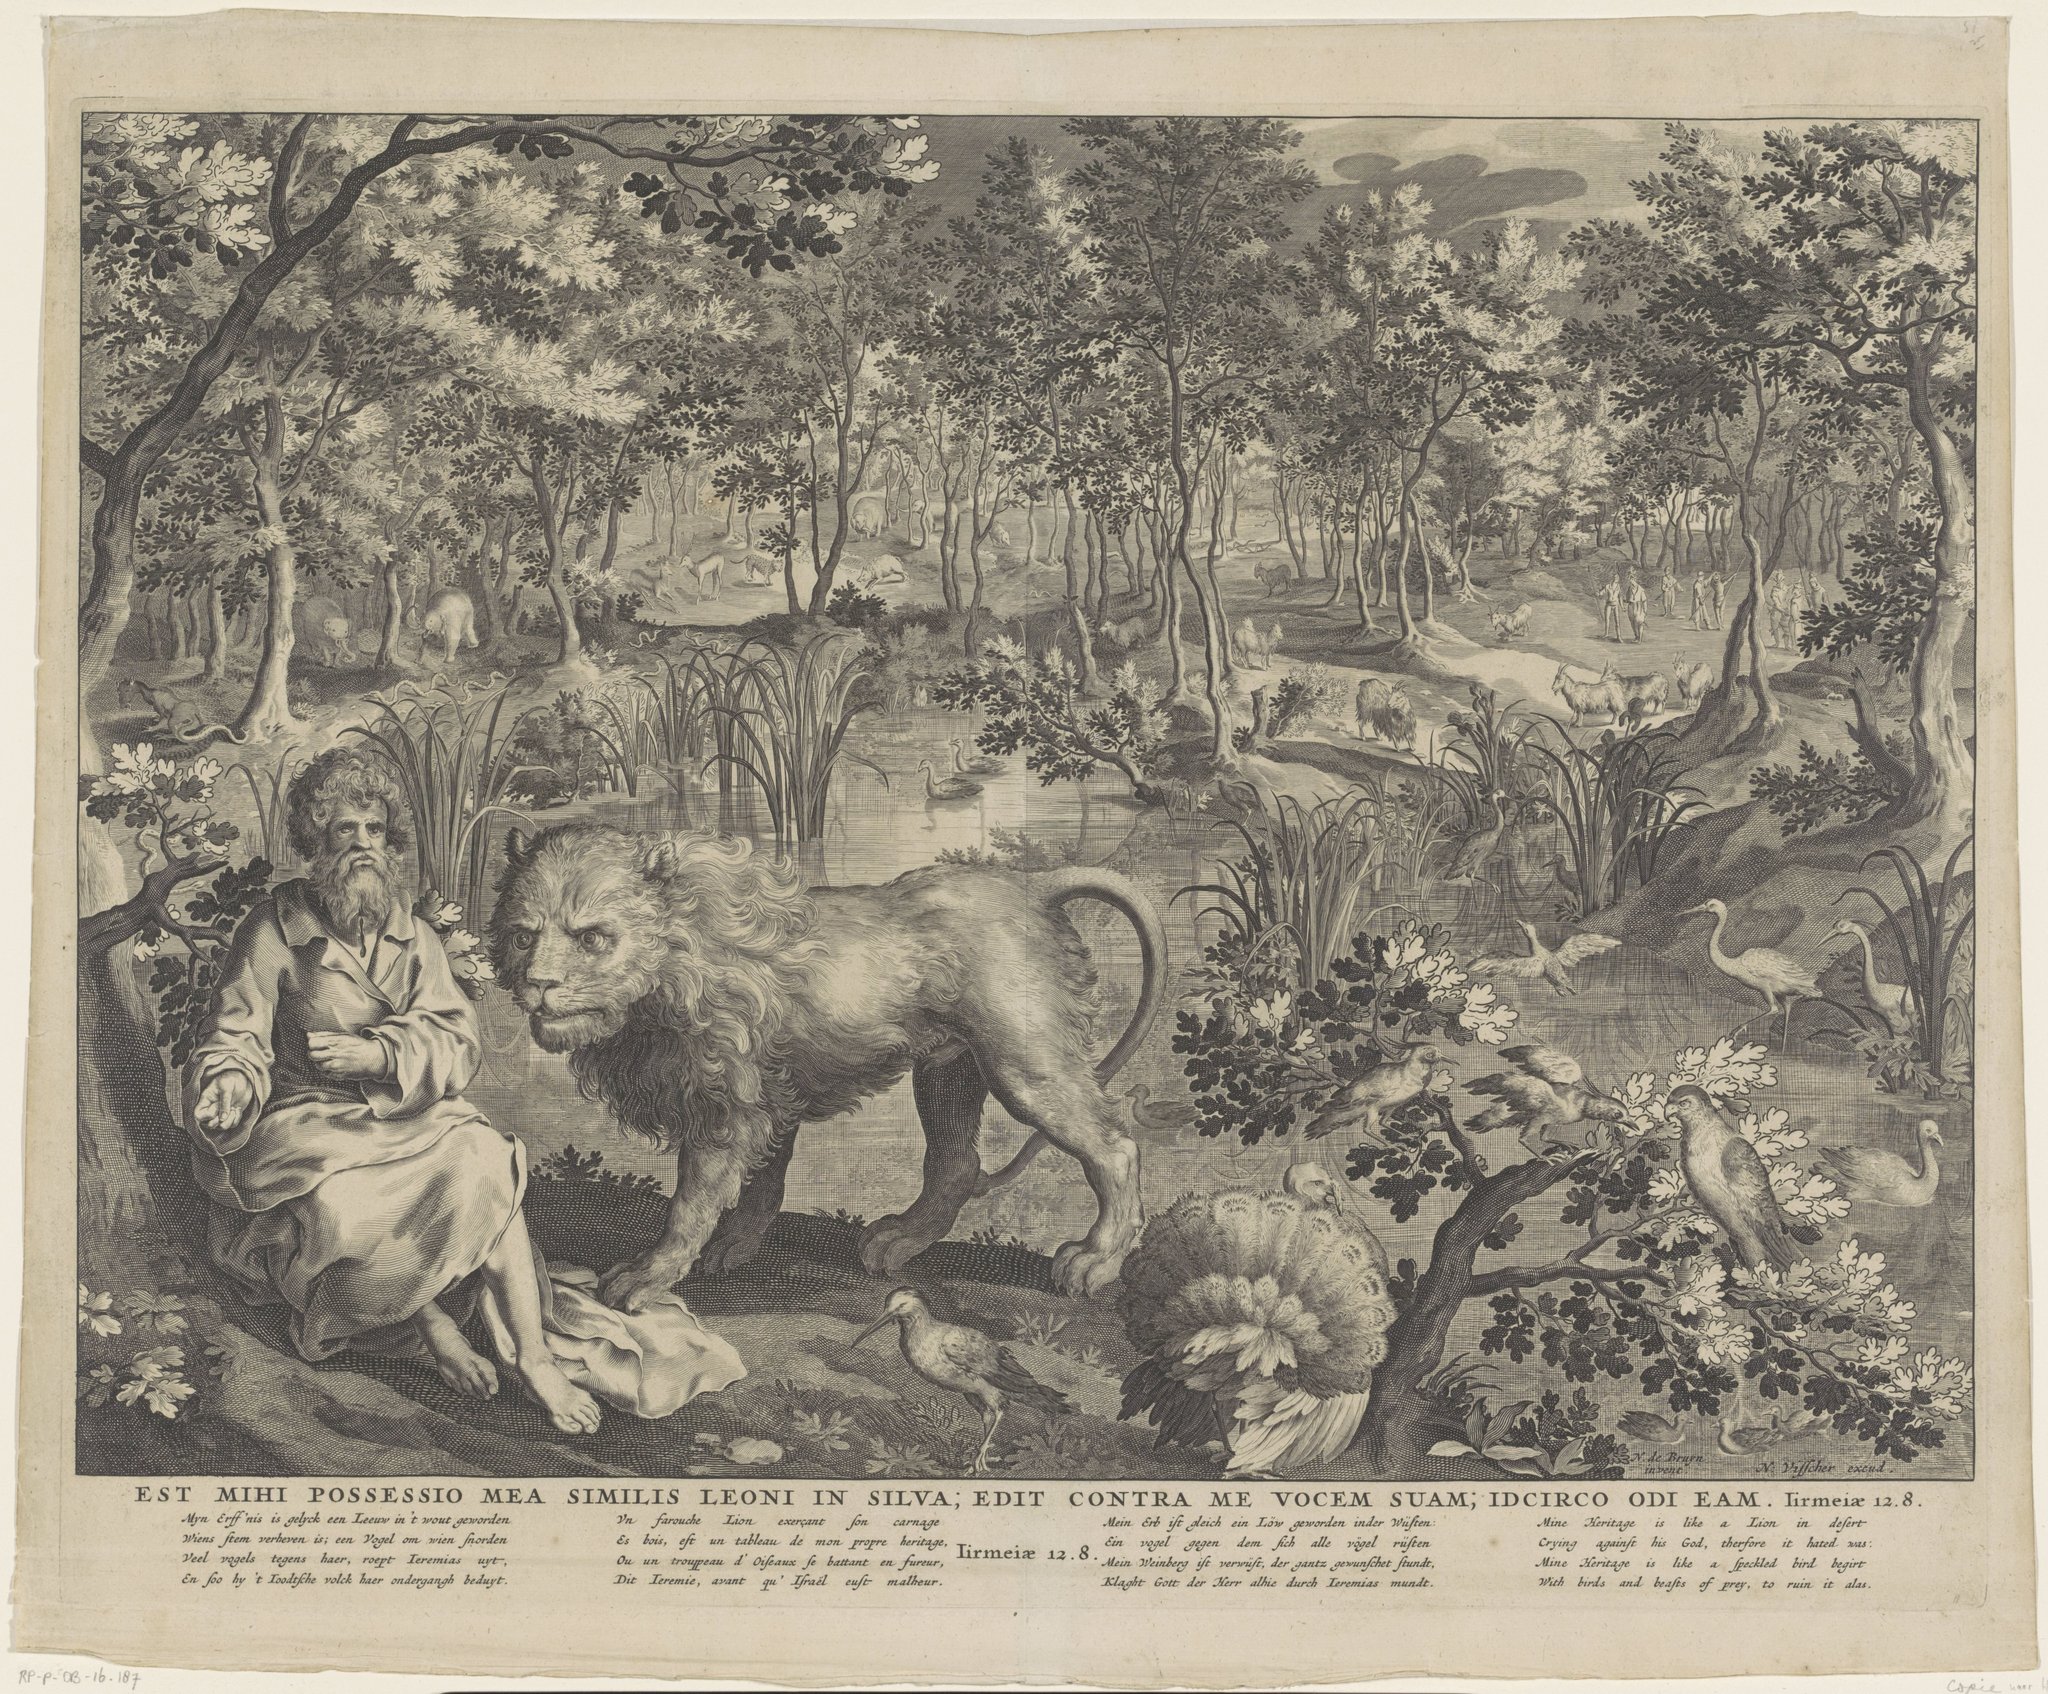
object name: print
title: Royaalbijbel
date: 1652-1702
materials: paper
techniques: engraving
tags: other scenes ~ the book of jeremiah, landscapes in the temperate zone, beasts of prey, predatory animals: lion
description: De Amsterdamse uitgever Claes Jansz. Visscher (II) produceerde vanaf de jaren ’30 van de zeventiende eeuw grote Bijbelse prenten op zogenaamd royaal-formaat papier (ca. 480 x 580 mm). Na zijn dood in 1652 zette zijn zoon Nicolaes Visscher (I) het bedrijf voort en zo ook de uitgave van Royaalbijbelprenten. Toen Nicolaes in 1679 overleed nam zijn zoon Nicolaes Visscher (II) het bedrijf over en gaf kort hierna, omstreeks 1680, een fondslijst uit. Hierin worden 130 prenten met Bijbelse voorstellingen op royaalpapier beschreven (zie documentatie J. van der Waals). Complete prentbijbels op royaal-formaat werden door vader en zoon Nicolaes Visscher uitgegeven onder de titel Historiae Sacrae Veteris et Novi Testamenti. De bladen werden echter ook los verkocht en konden worden gecombineerd met Royaalbijbel-prenten van andere uitgevers. Verschillende Amsterdamse uitgevers brachten namelijk ook bijbelprenten op royaal-formaat uit, onder wie Clement de Jonghe en Cornelis Danckerts. De door de firma Visscher uitgegeven prenten zijn veelal vervaardigd door anonieme prentmakers naar voorbeeld van verschillende zestiende- en zeventiende-eeuwse Bijbelse prenten en prentreeksen. Veelal moesten de composities worden aangepast aan het grotere en langgerekte royaal-formaat. Daarnaast zijn er ook grote bladen van bekende prentmakers zoals Jan van Londerseel, Pieter Nolpe, Jacques de Gheyn (II) en Jan Harmensz. Muller opgenomen in de categorie ‘Bybelsche Figuren, op Royaal-bladen’ in de fondslijst van Visscher. Prent mogelijk gebruikt in: Historiae Sacrae Veteris et Novi Testamenti (Royaalbijbel). Amsterdam: Nicolaes Visscher (I) en (II), [1652-1702]. In de fondslijst van Nicolaes Visscher II (ca. 1680) is het onderwerp van deze prent onder de titel 'Bybelsche Figuren, op Royaal-bladen. bestaande uyt de volgende historien.' als volgt genummerd: 57.